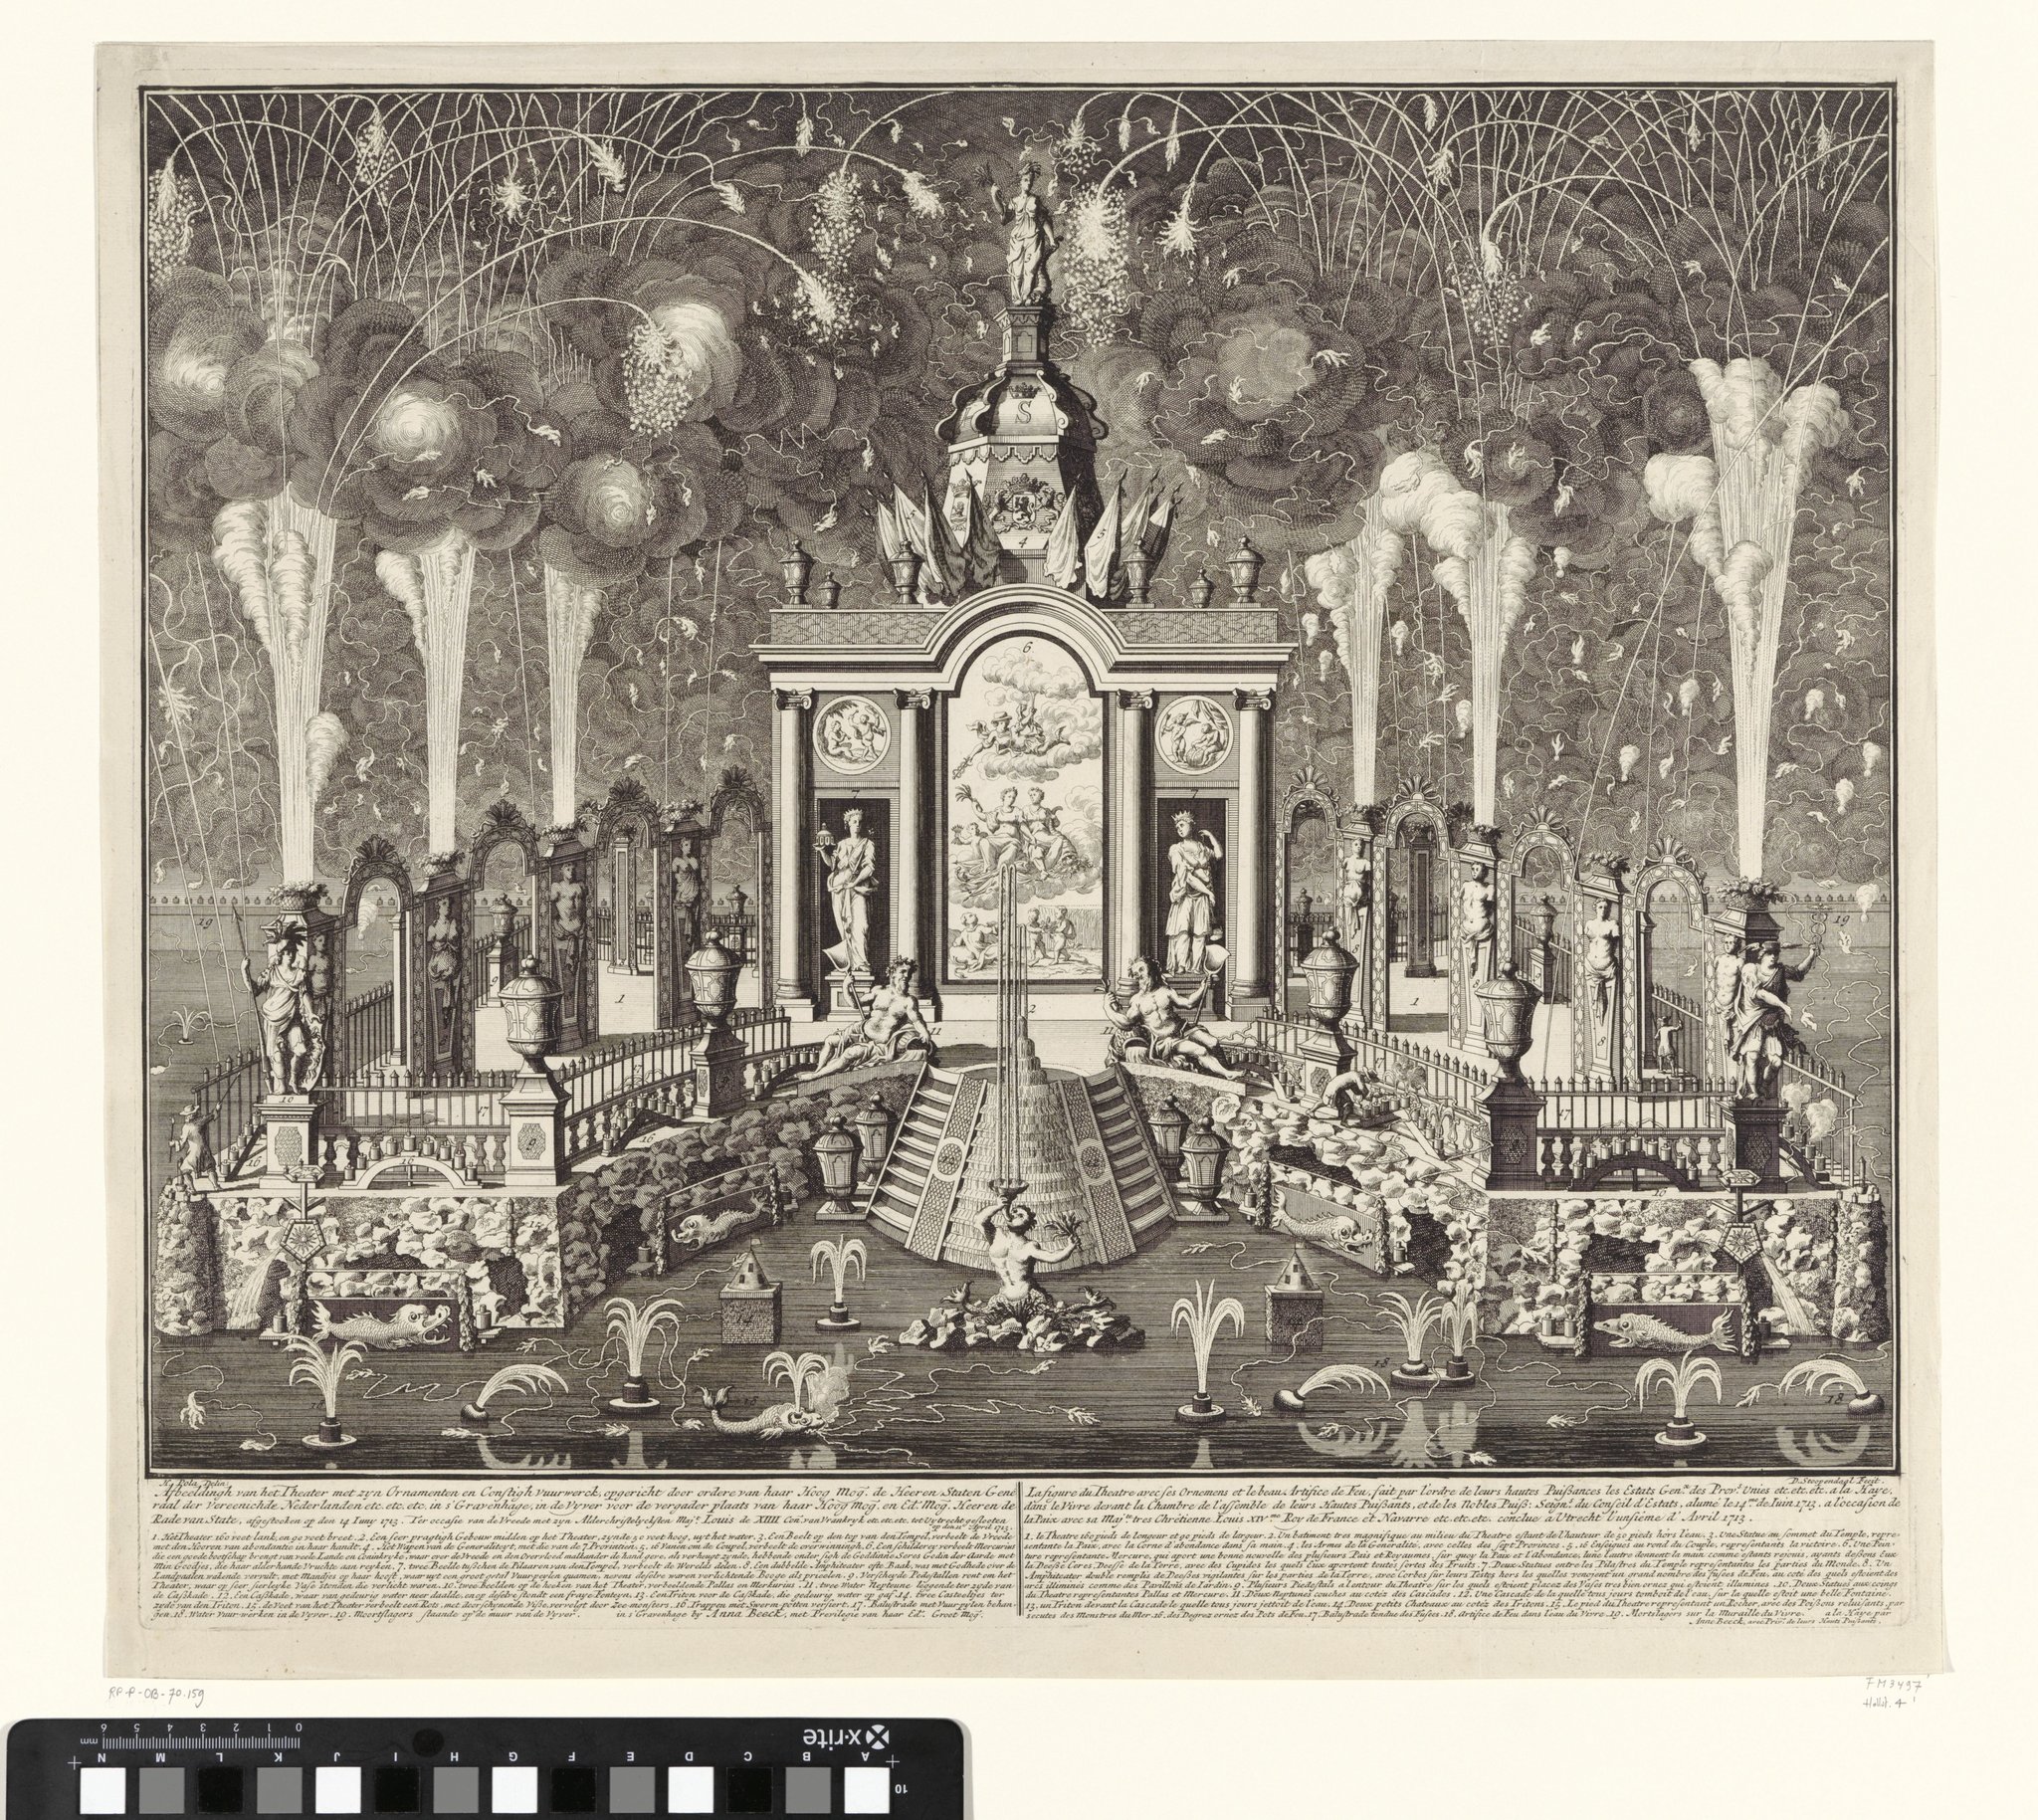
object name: print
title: Vuurwerk bij de viering van de Vrede van Utrecht, 1713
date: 1713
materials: paper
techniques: engraving, etching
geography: the hague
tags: bonfire, fire-works, festivities (+ illumination, fire-works ~ festive activities)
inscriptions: collector's mark: Lugt 2228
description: Stellage met vuurwerk afgestoken in opdracht van de Staten-Generaal op de Hofvijver te Den Haag bij de viering van de Vrede van Utrecht, 14 juni 1713. In de vijver is een tempel opgericht met een schilderij waarop Vrede en Overvloed tronen op de wolken en Mercurius een goede tijding brengt. Onderaan de titel en legenda 1-19 in het Nederlands en Frans.